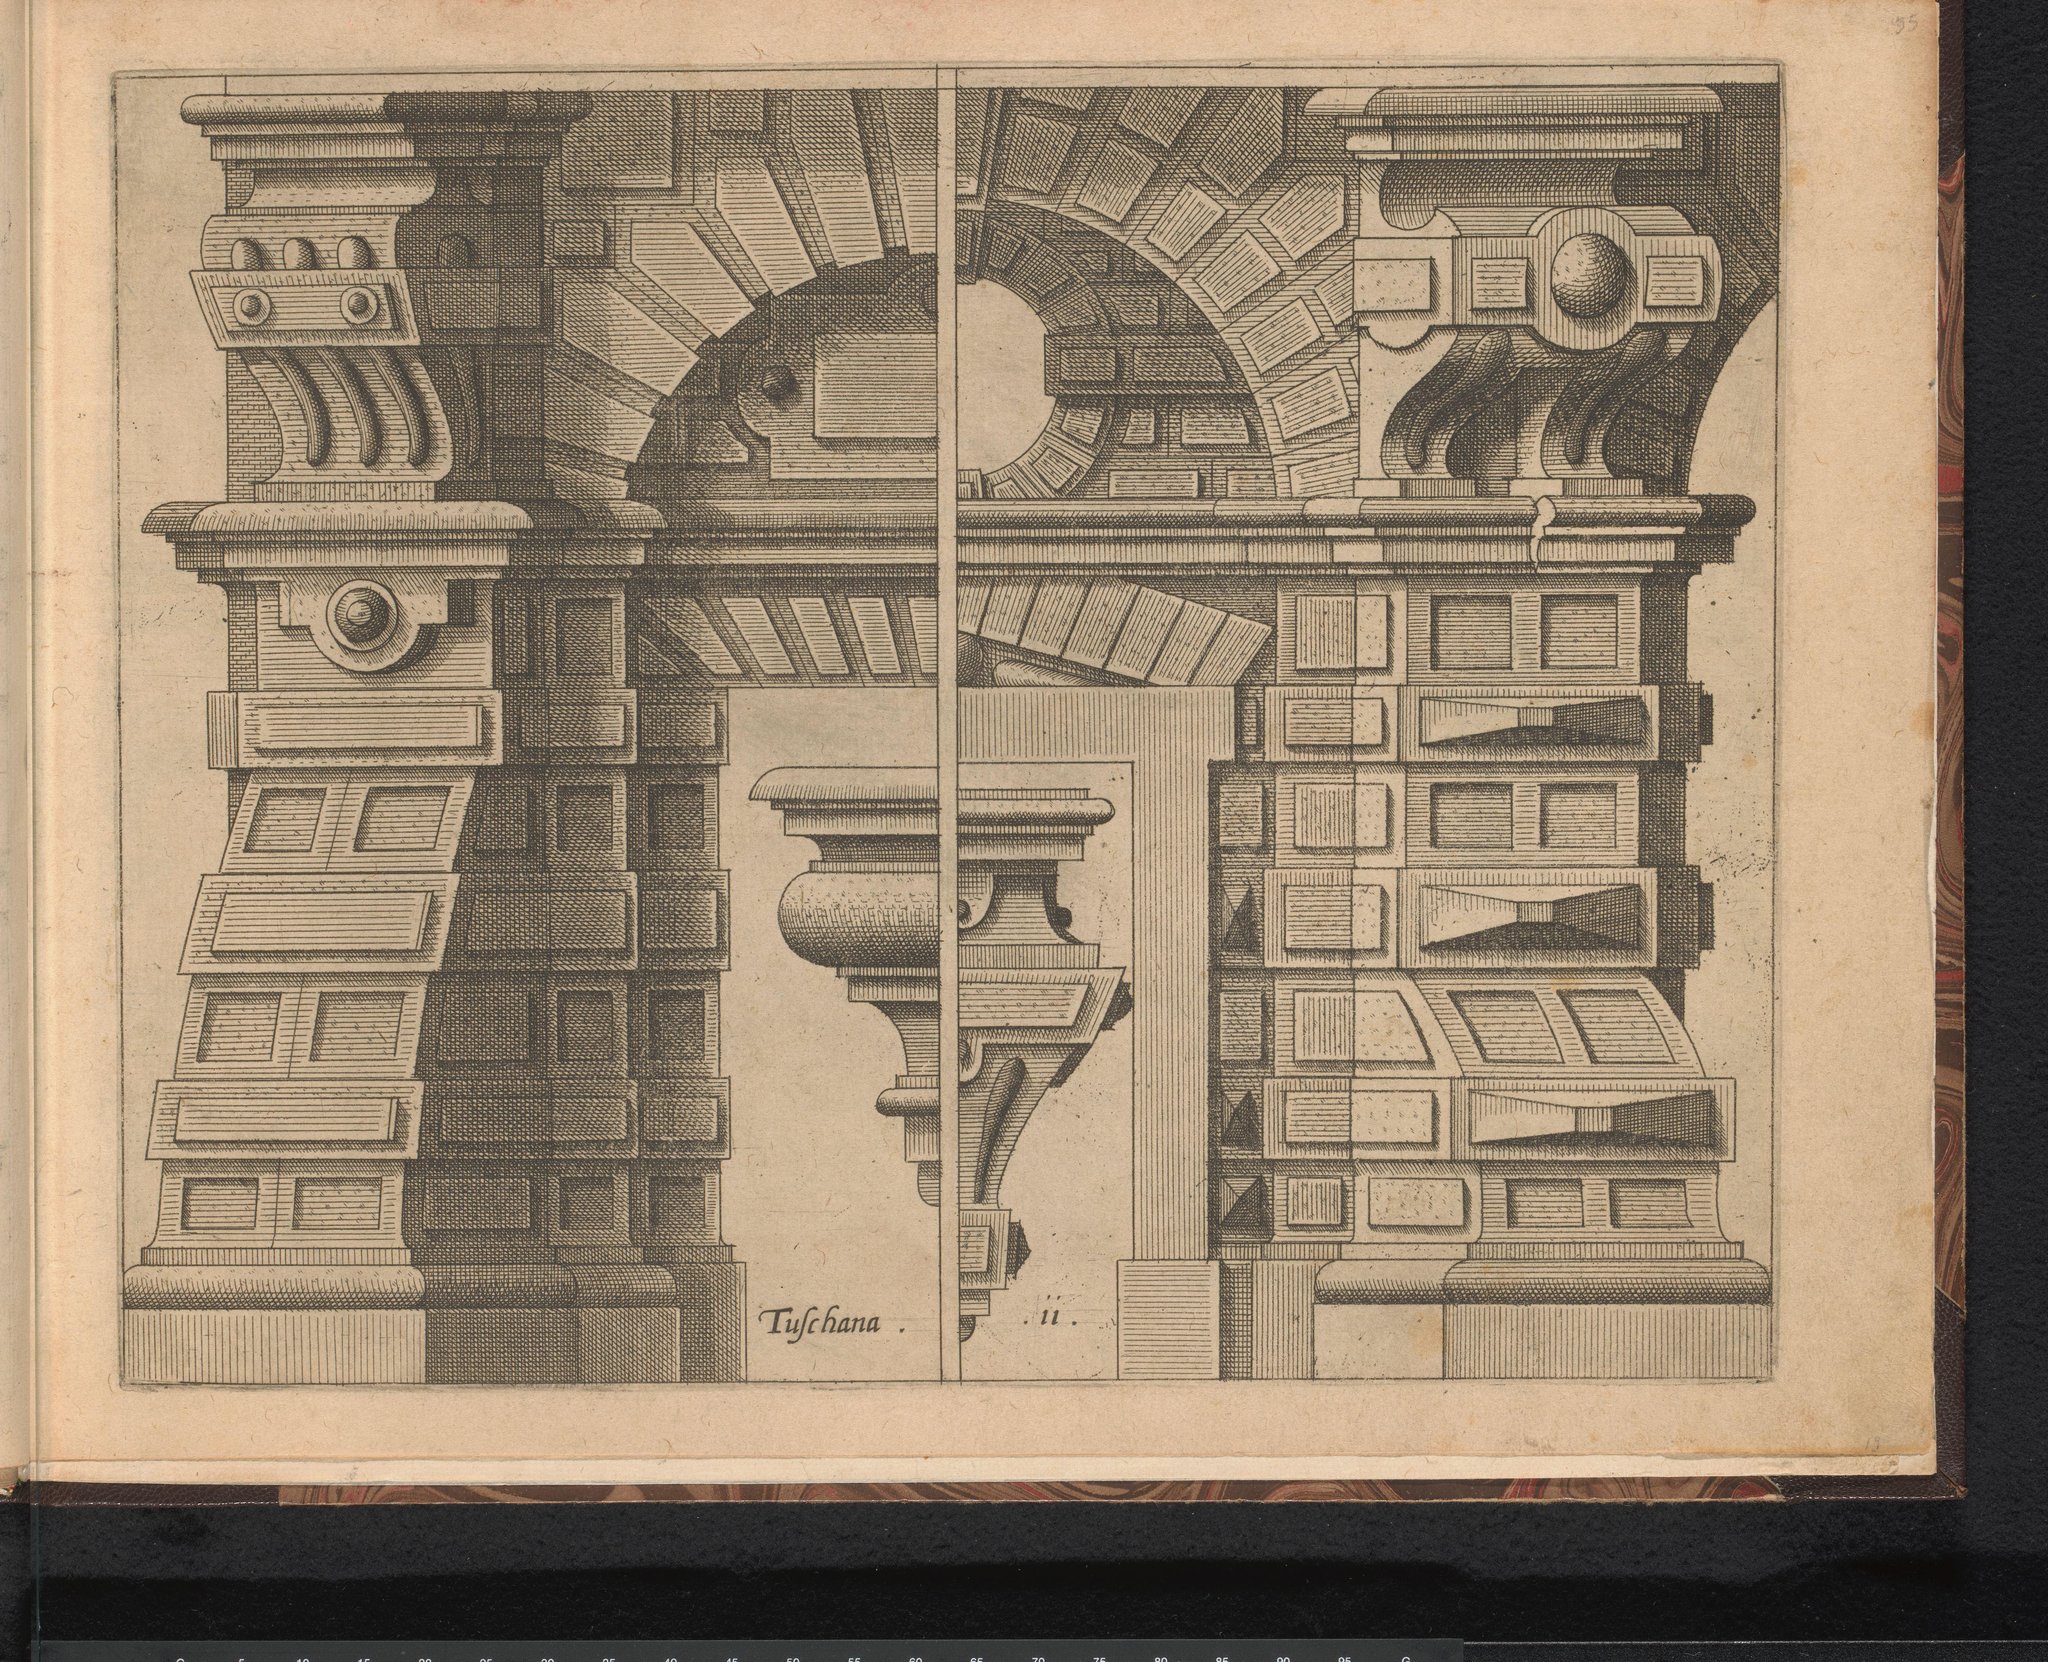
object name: ornament print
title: Twee halve portalen en twee consoles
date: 1578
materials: paper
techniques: etching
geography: antwerp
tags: tuscan order ~ architecture, other architectural details (console), gate, entrance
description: Twee halve portalen in de Toscaanse Orde, geflankeerd door een pilaster in een muur van rustica. Het rechter portaal met 'oeil de boeuf' (klein rond, ovaal of achthoekig raam in de gevel van een gebouw, ook wel bekend als oculus). Daarbij twee consoles. De prent maakt deel uit van een album.